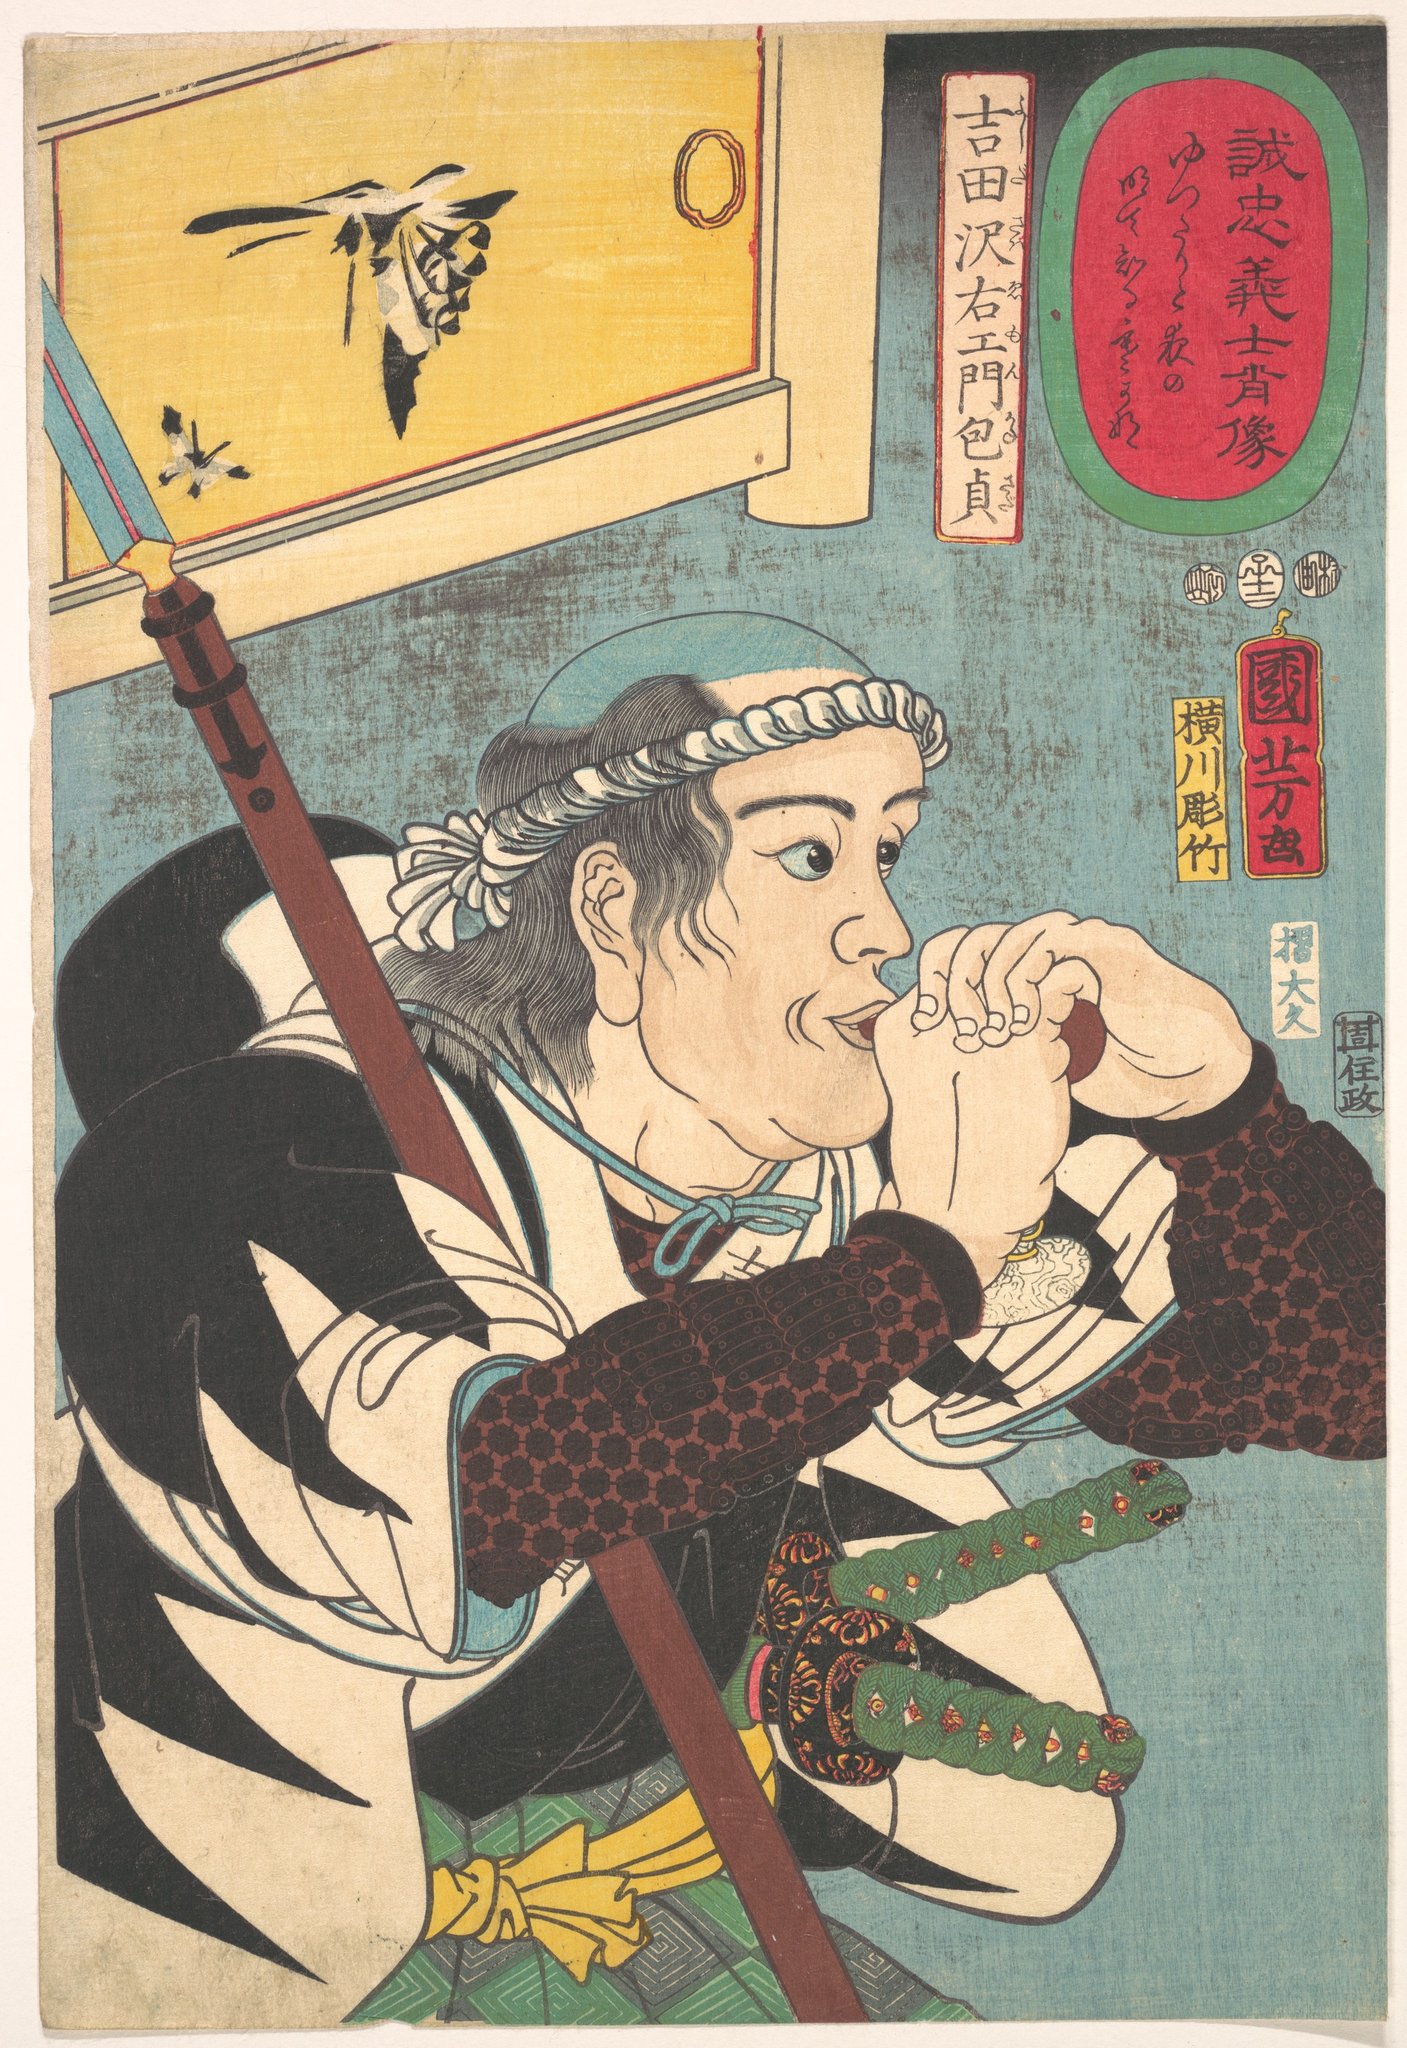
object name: print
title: Portrait of Yoshida Sayaemon Kanesada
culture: japanese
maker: utagawa kuniyoshi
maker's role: artist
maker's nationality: japanese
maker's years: 1797-1861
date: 1852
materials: ink, paper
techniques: woodblock print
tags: weapons,men,portraits